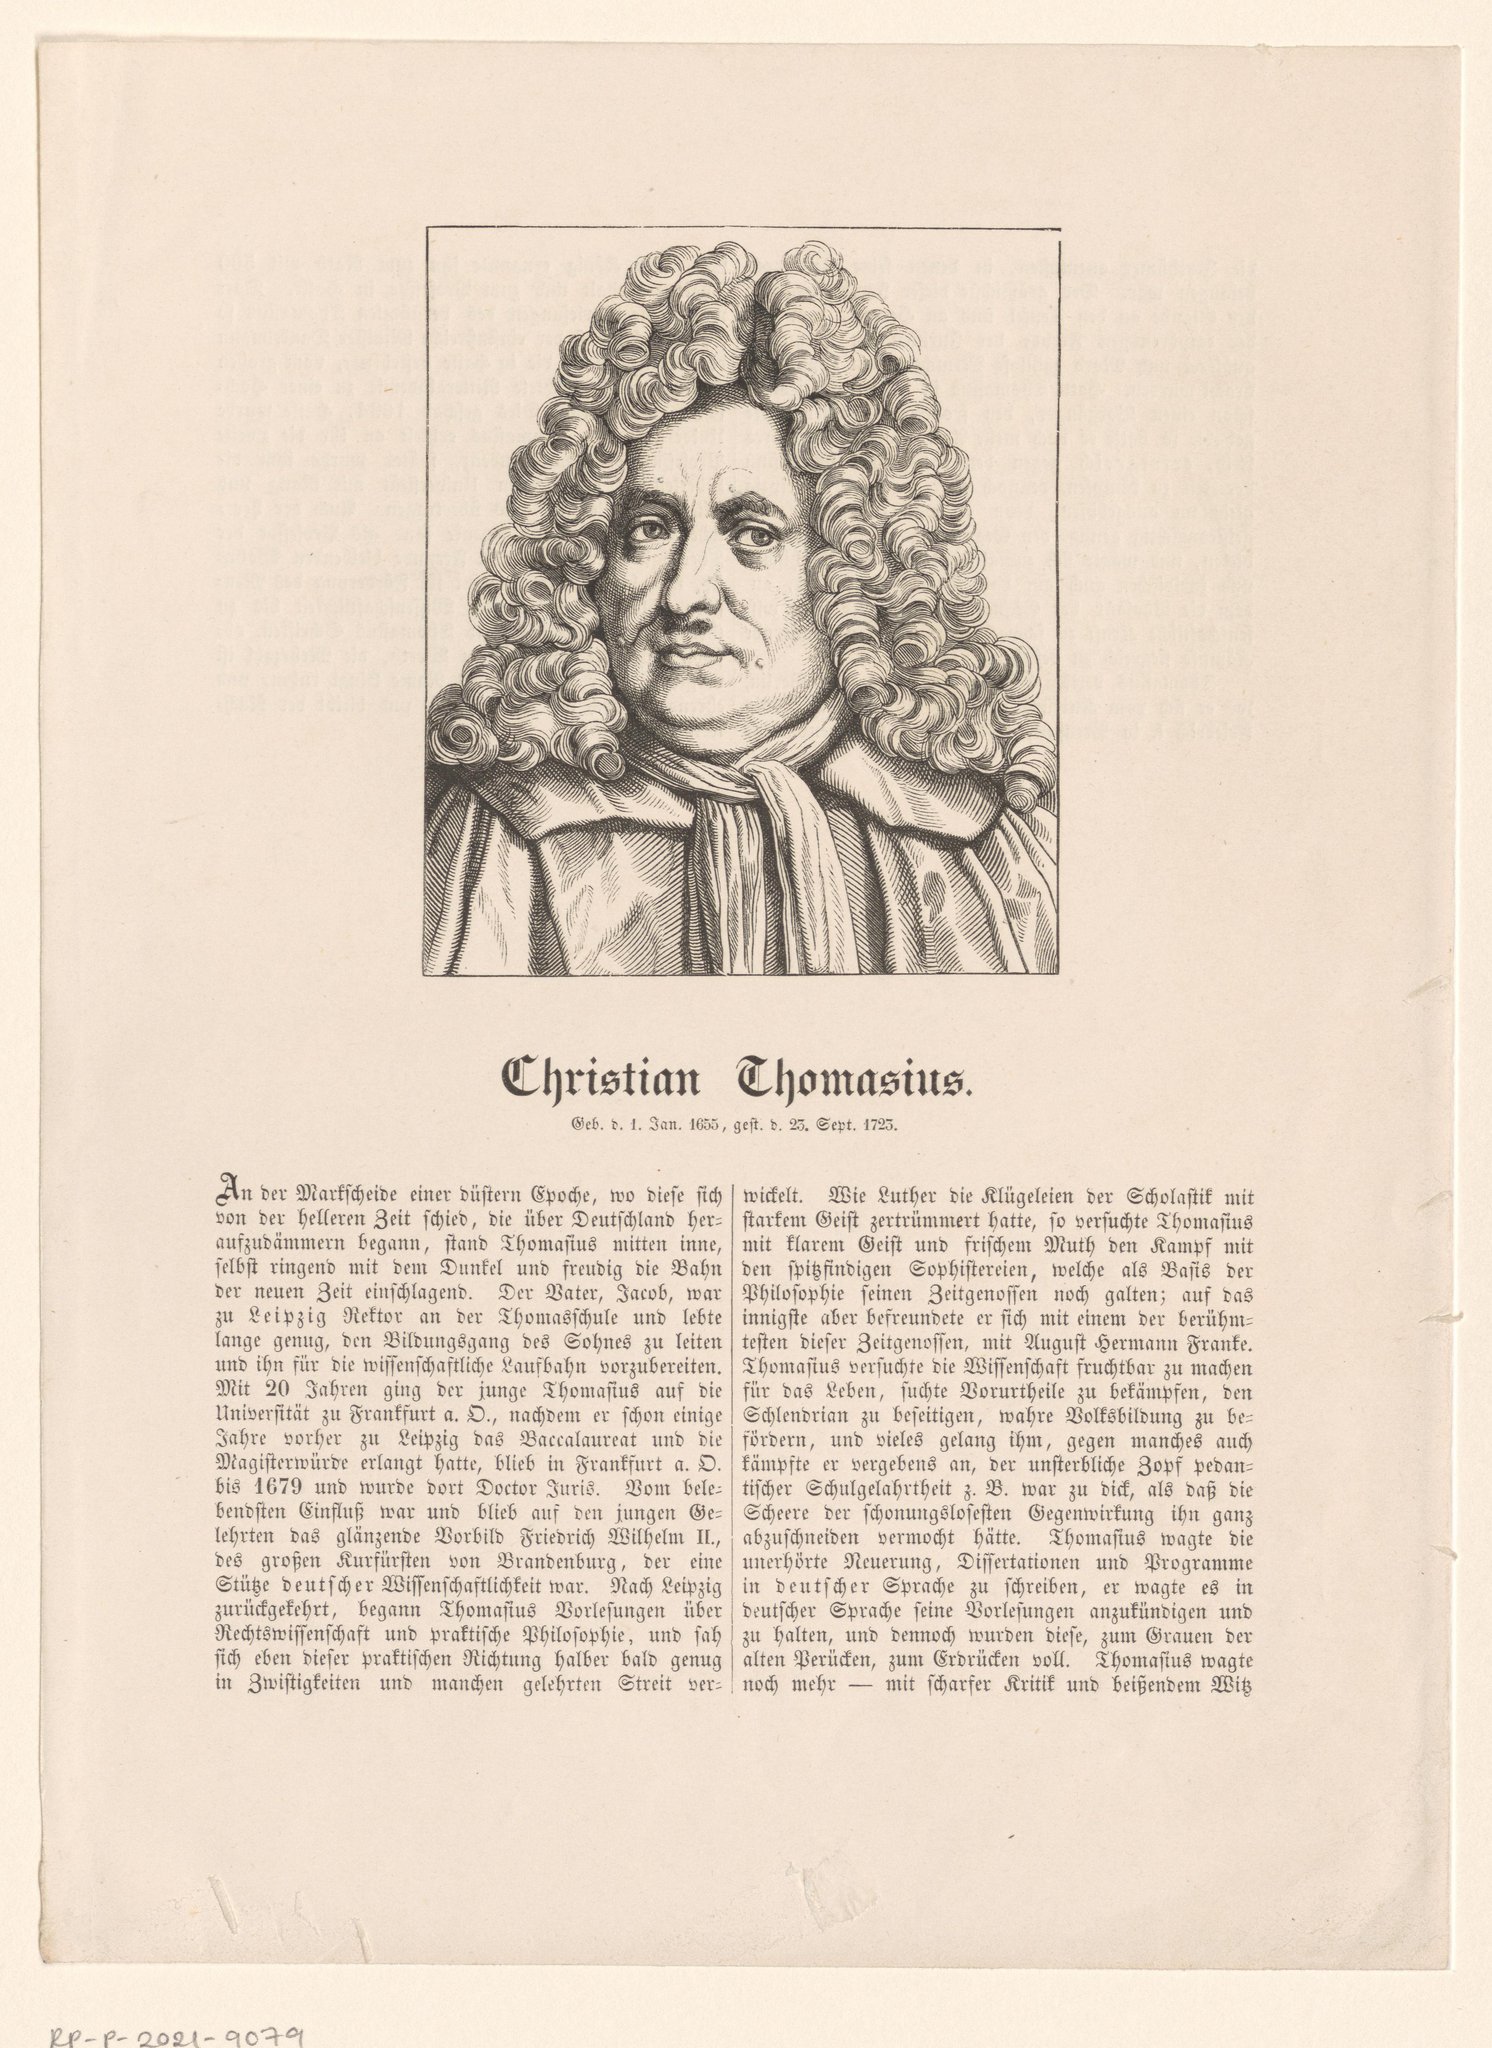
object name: book illustration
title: Portret van Christian Thomasius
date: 1854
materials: paper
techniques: letterpress printing, engraving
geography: leipzig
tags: christian thomasius, scholar, philosopher, historical persons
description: Prent uit: Bechstein, Ludwig. Zweihundert deutsche Männer in Bildnissen und Lebensbeschreibungen. Leipzig: Georg Wigand, 1854.